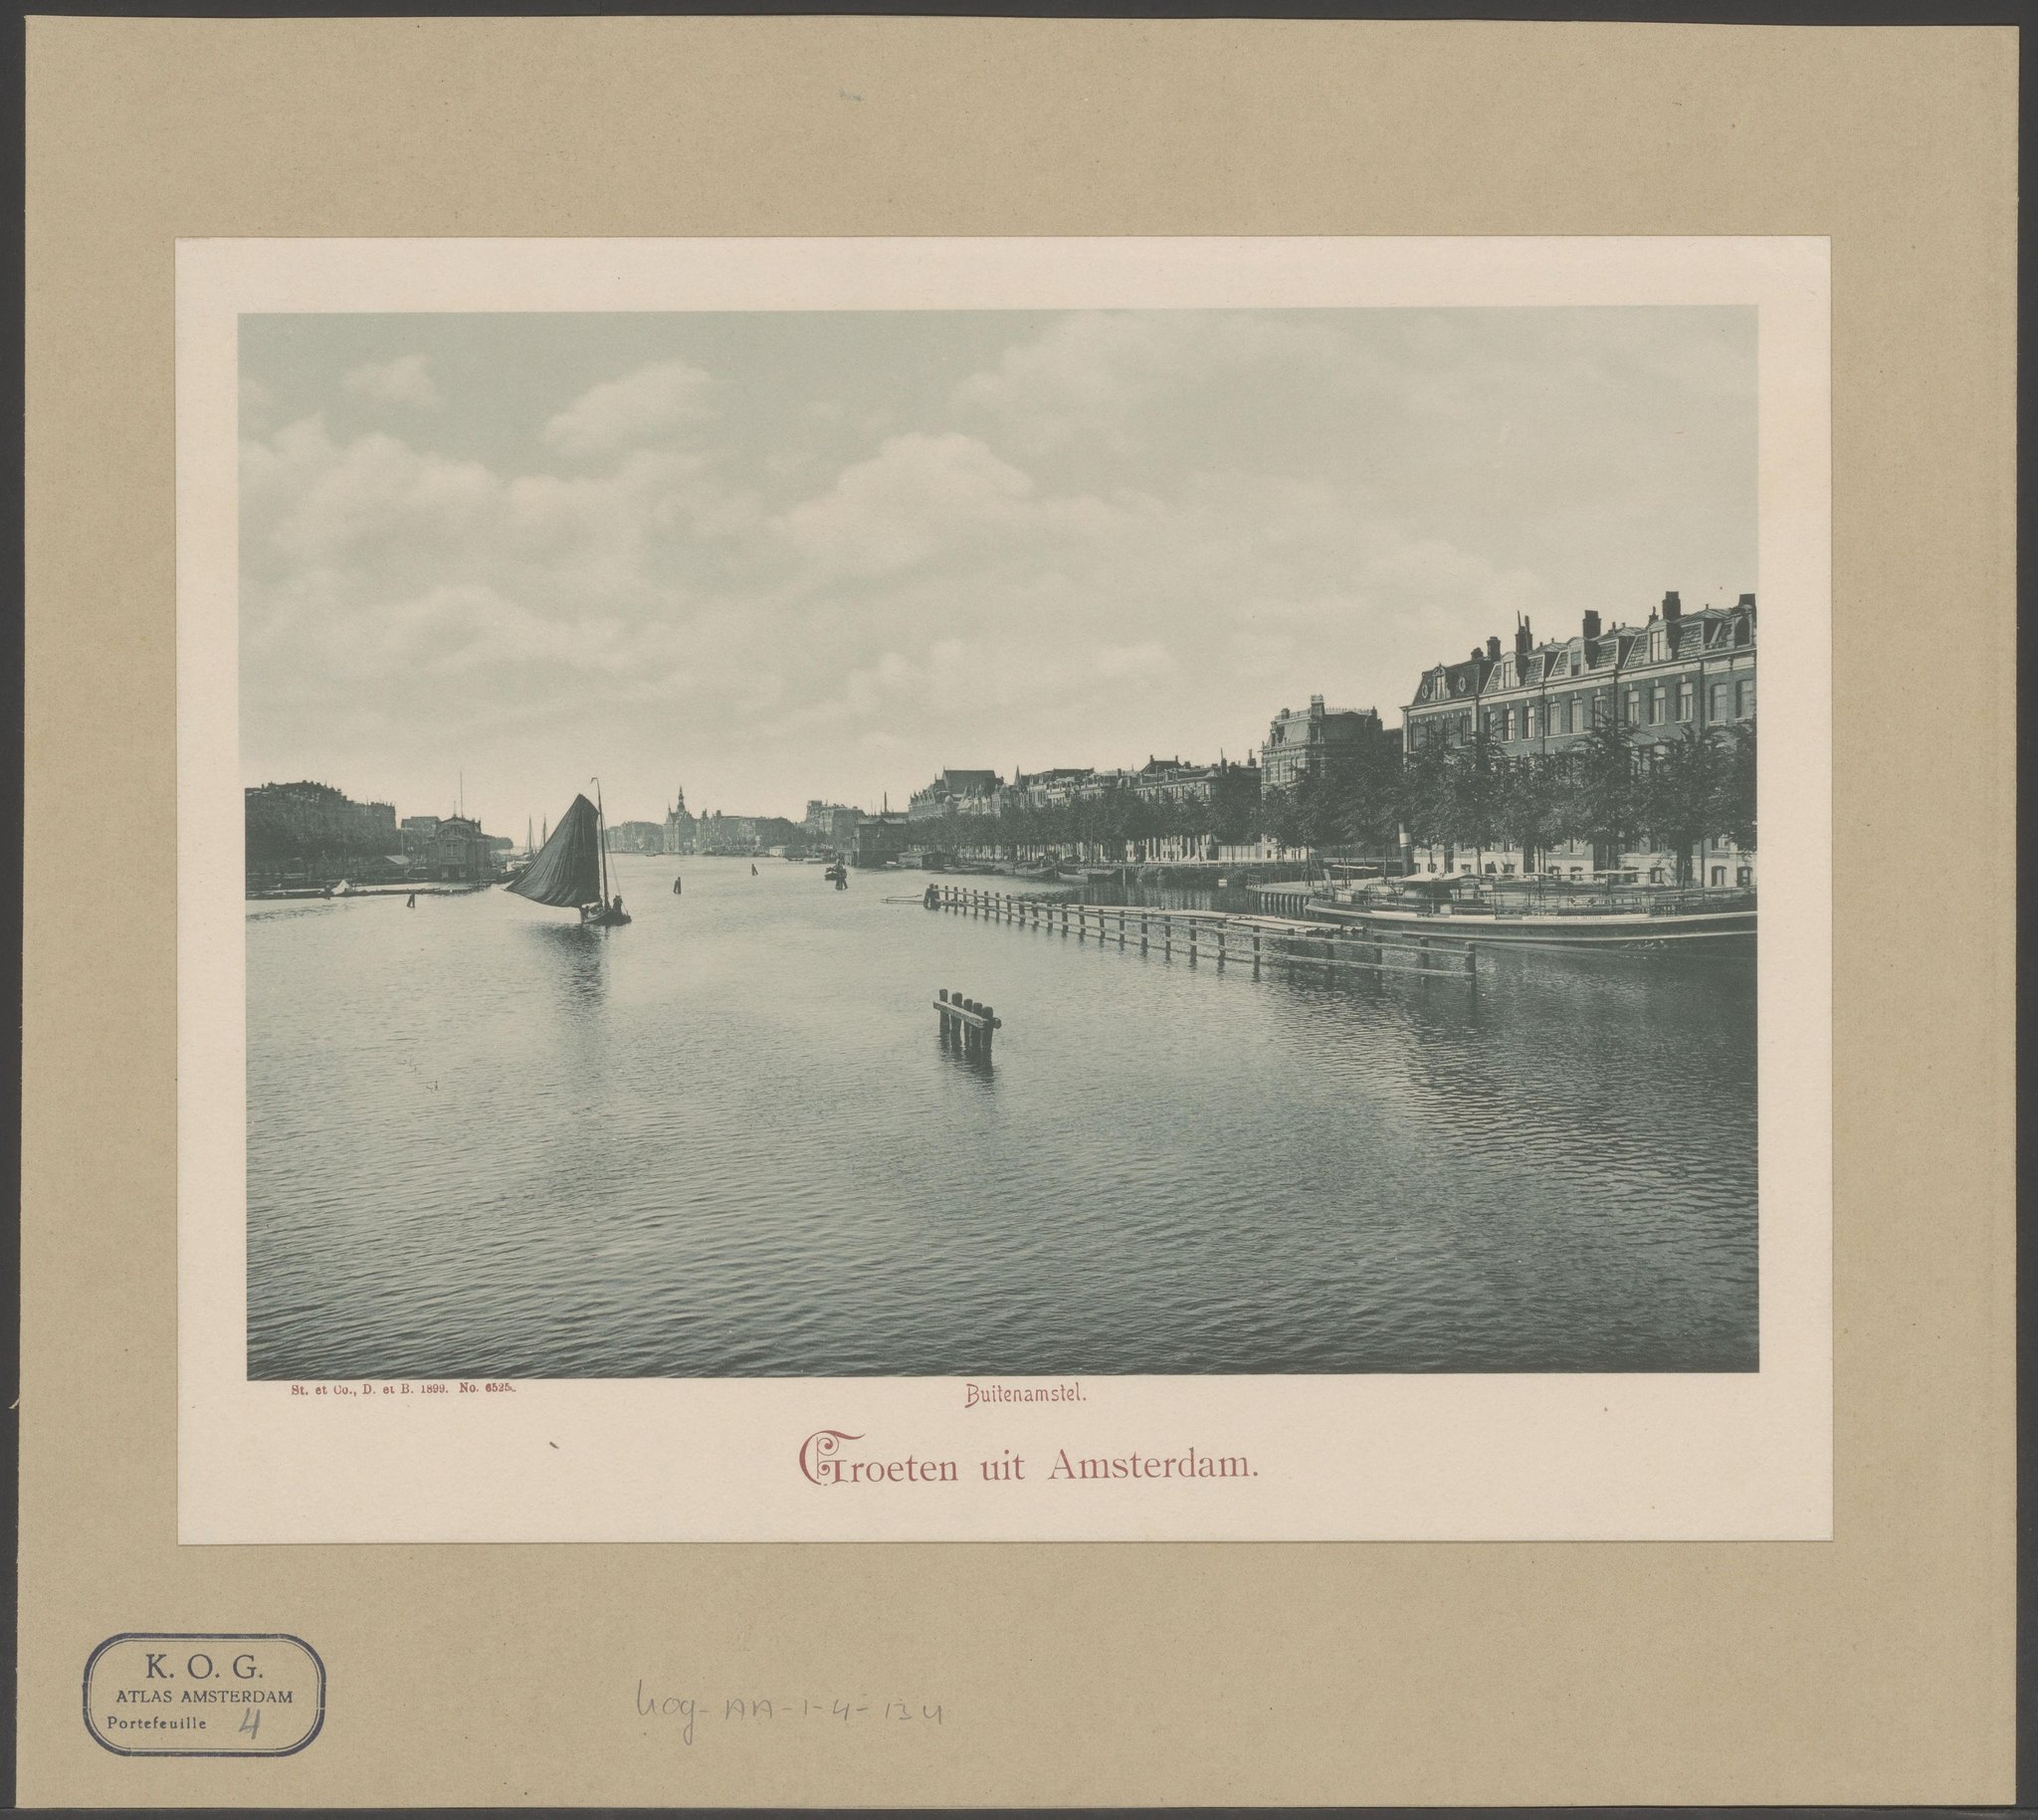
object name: photomechanical print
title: Gezicht op de Buiten-Amstel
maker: Anonymous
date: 1875-1950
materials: cardboard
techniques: photograph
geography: germany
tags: city-view in general; 'veduta', river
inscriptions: collector's mark: ‘4’ Lugt 1641b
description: Onderwerpsrubriek binnen de Atlas Amsterdam: Amstel van Hogesluis stroomopwaarts.